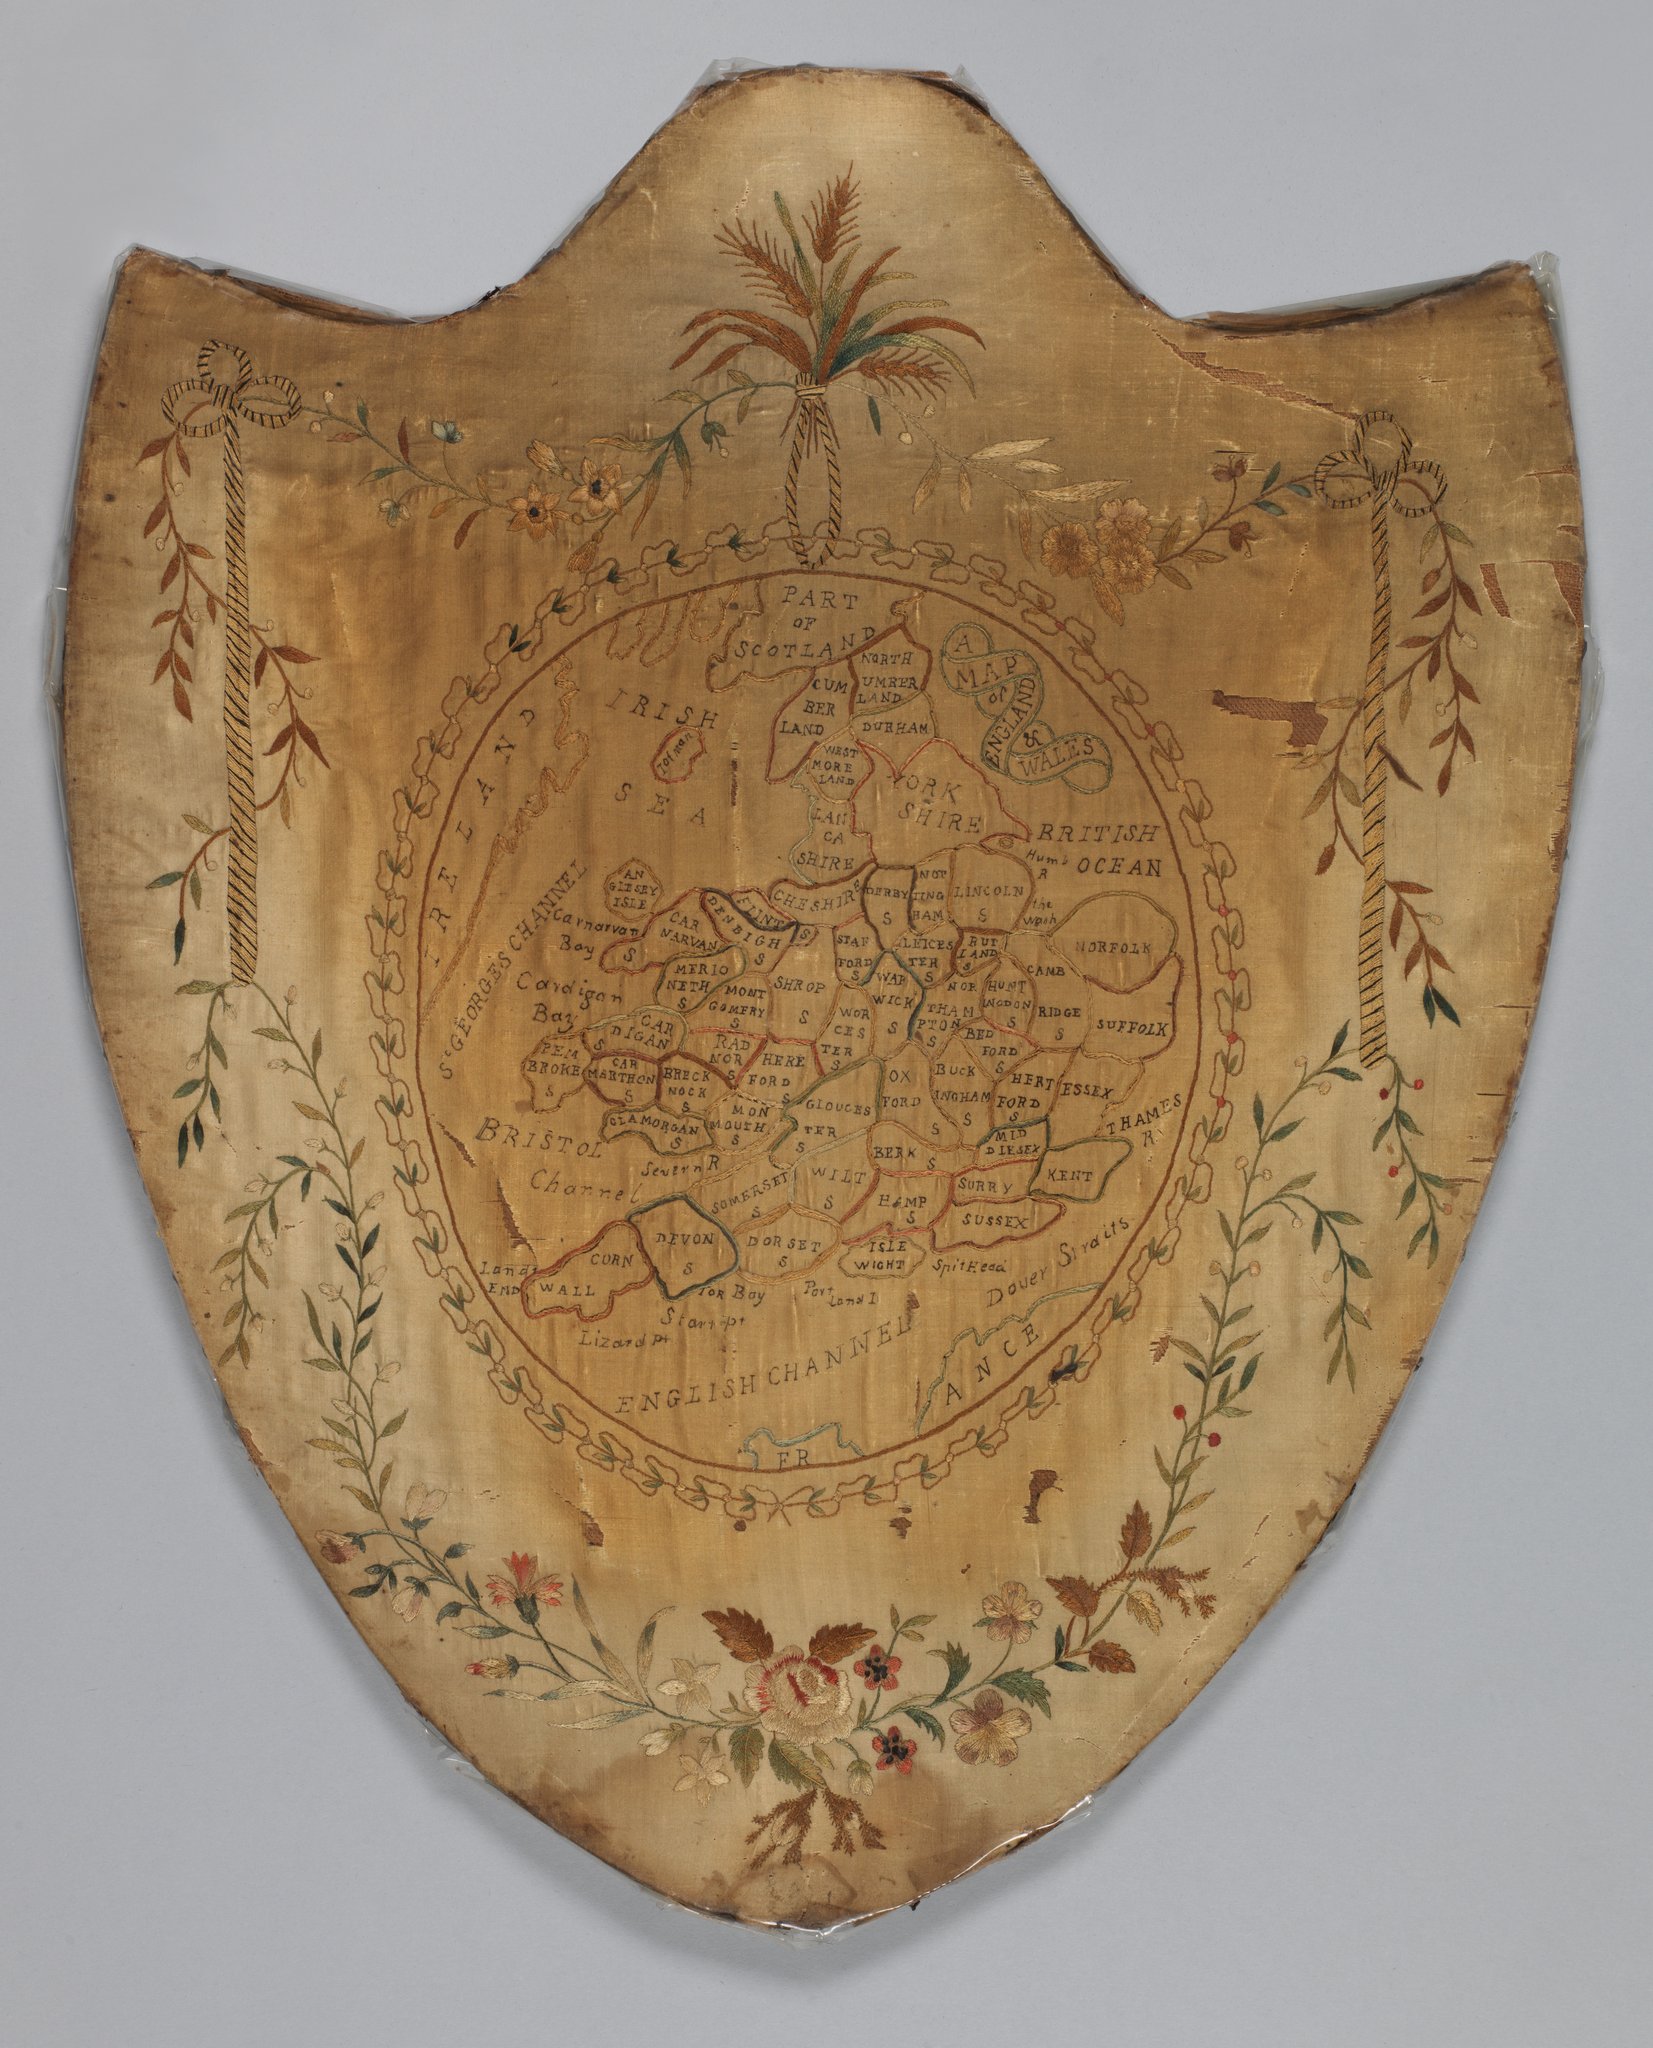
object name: sampler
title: Embroidered map sampler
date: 1767-1833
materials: silk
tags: flowers,maps